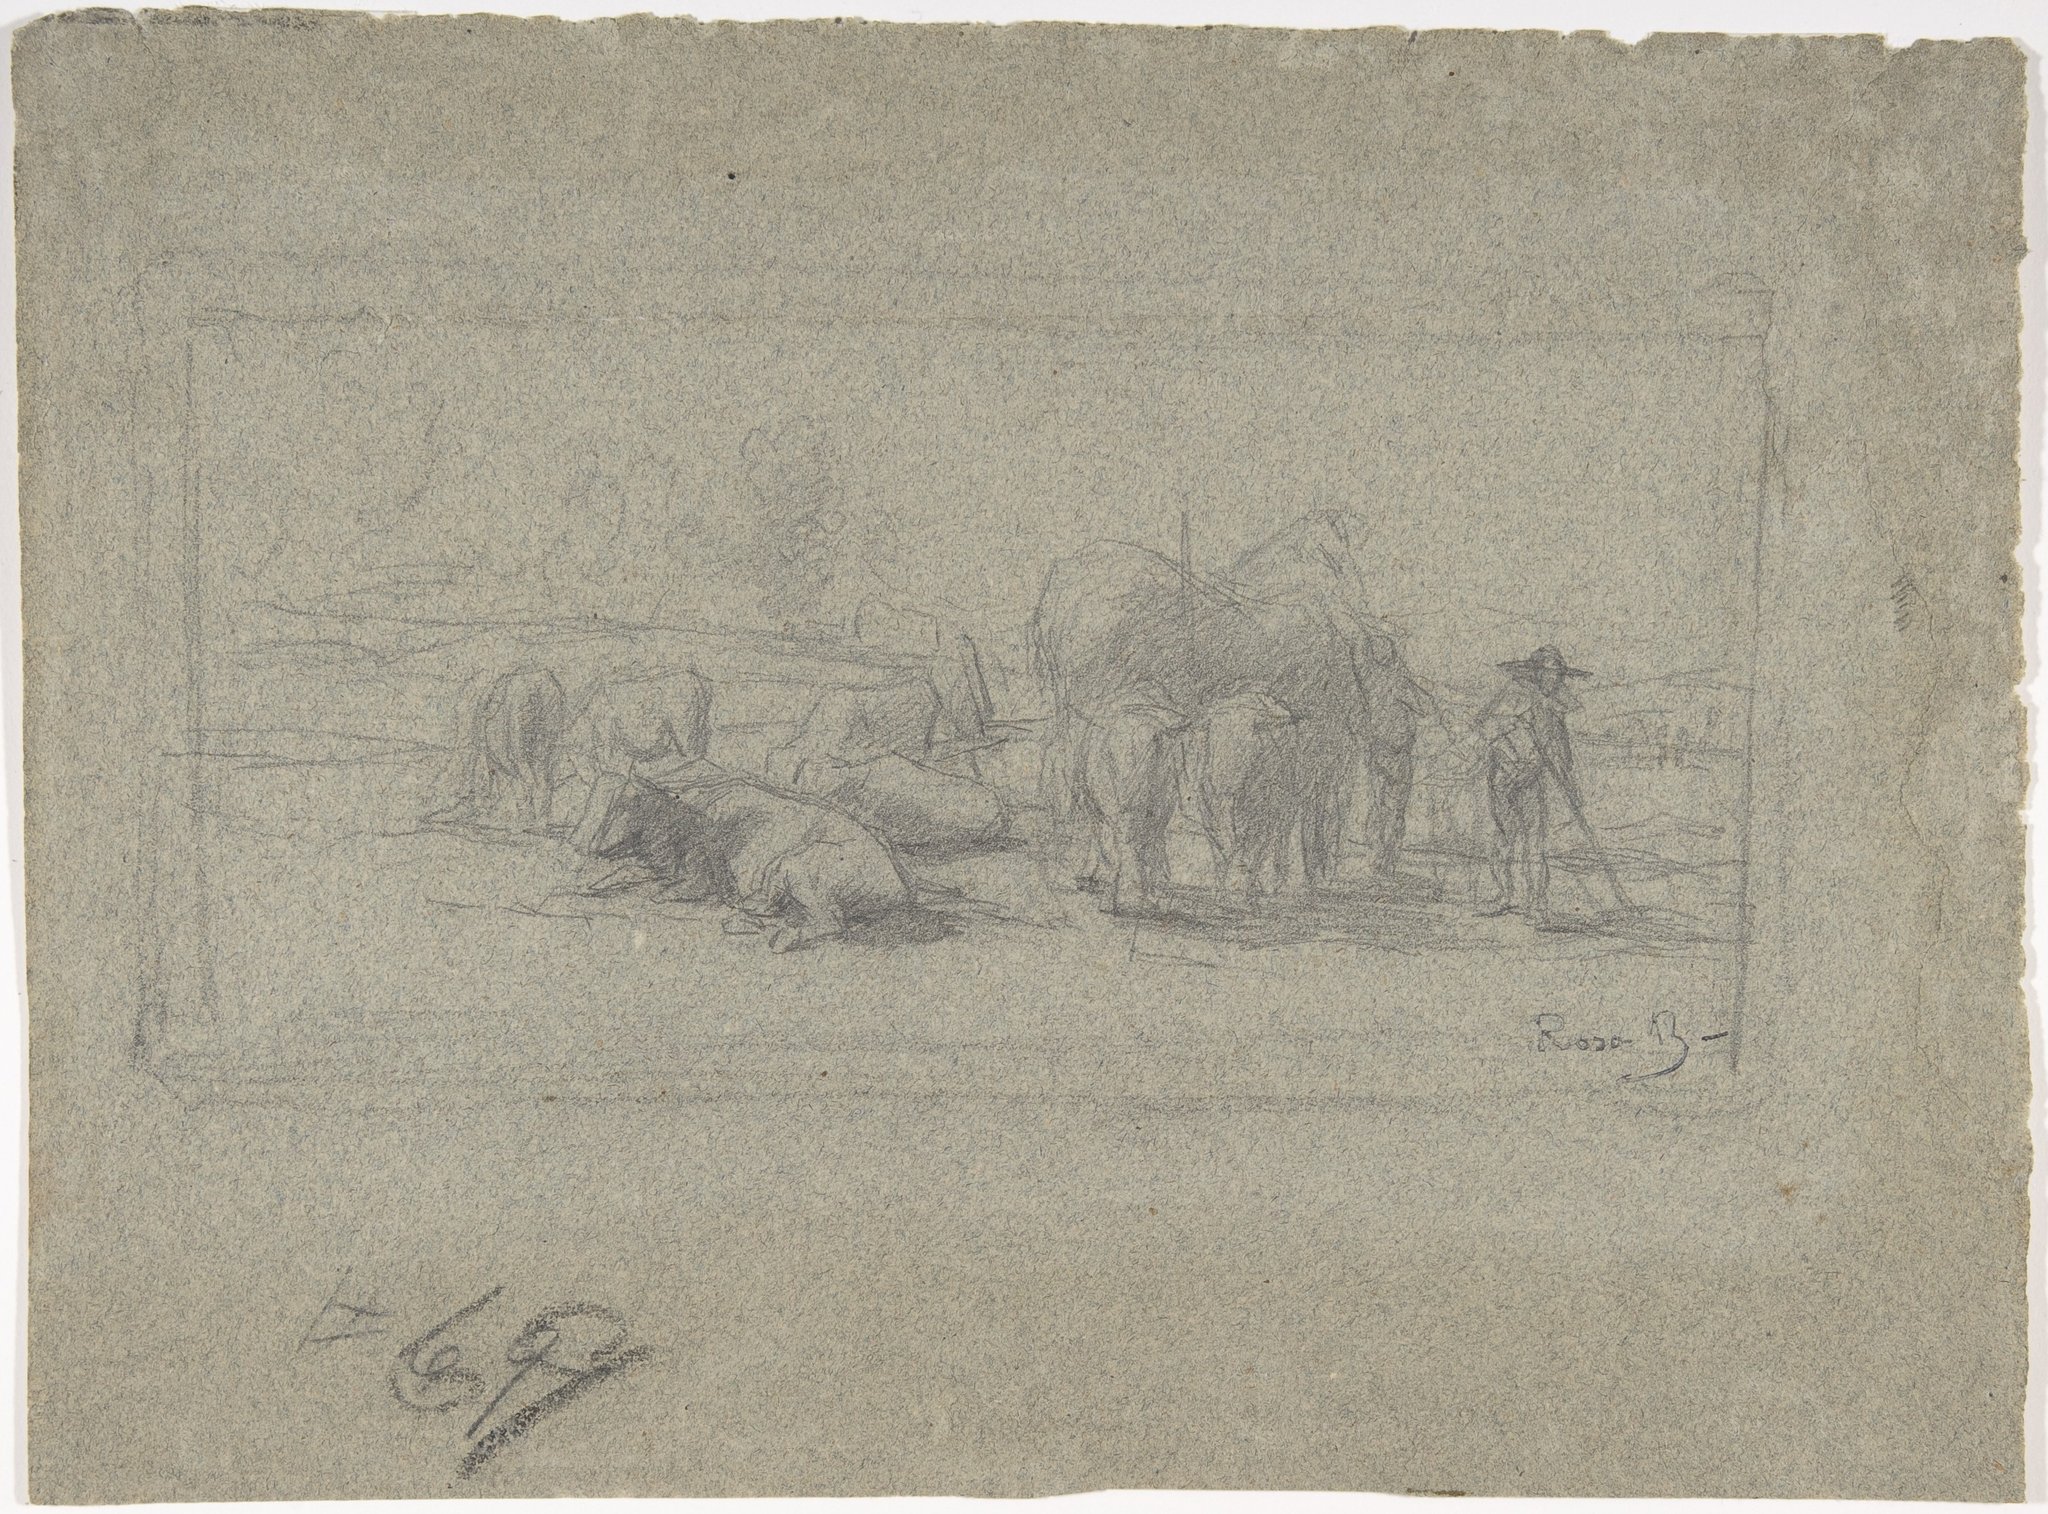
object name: drawing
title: Landscape with Cattle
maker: rosa bonheur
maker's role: artist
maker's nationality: french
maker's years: 1822-1899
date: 1820-1900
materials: graphite, paper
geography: france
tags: cows,landscapes